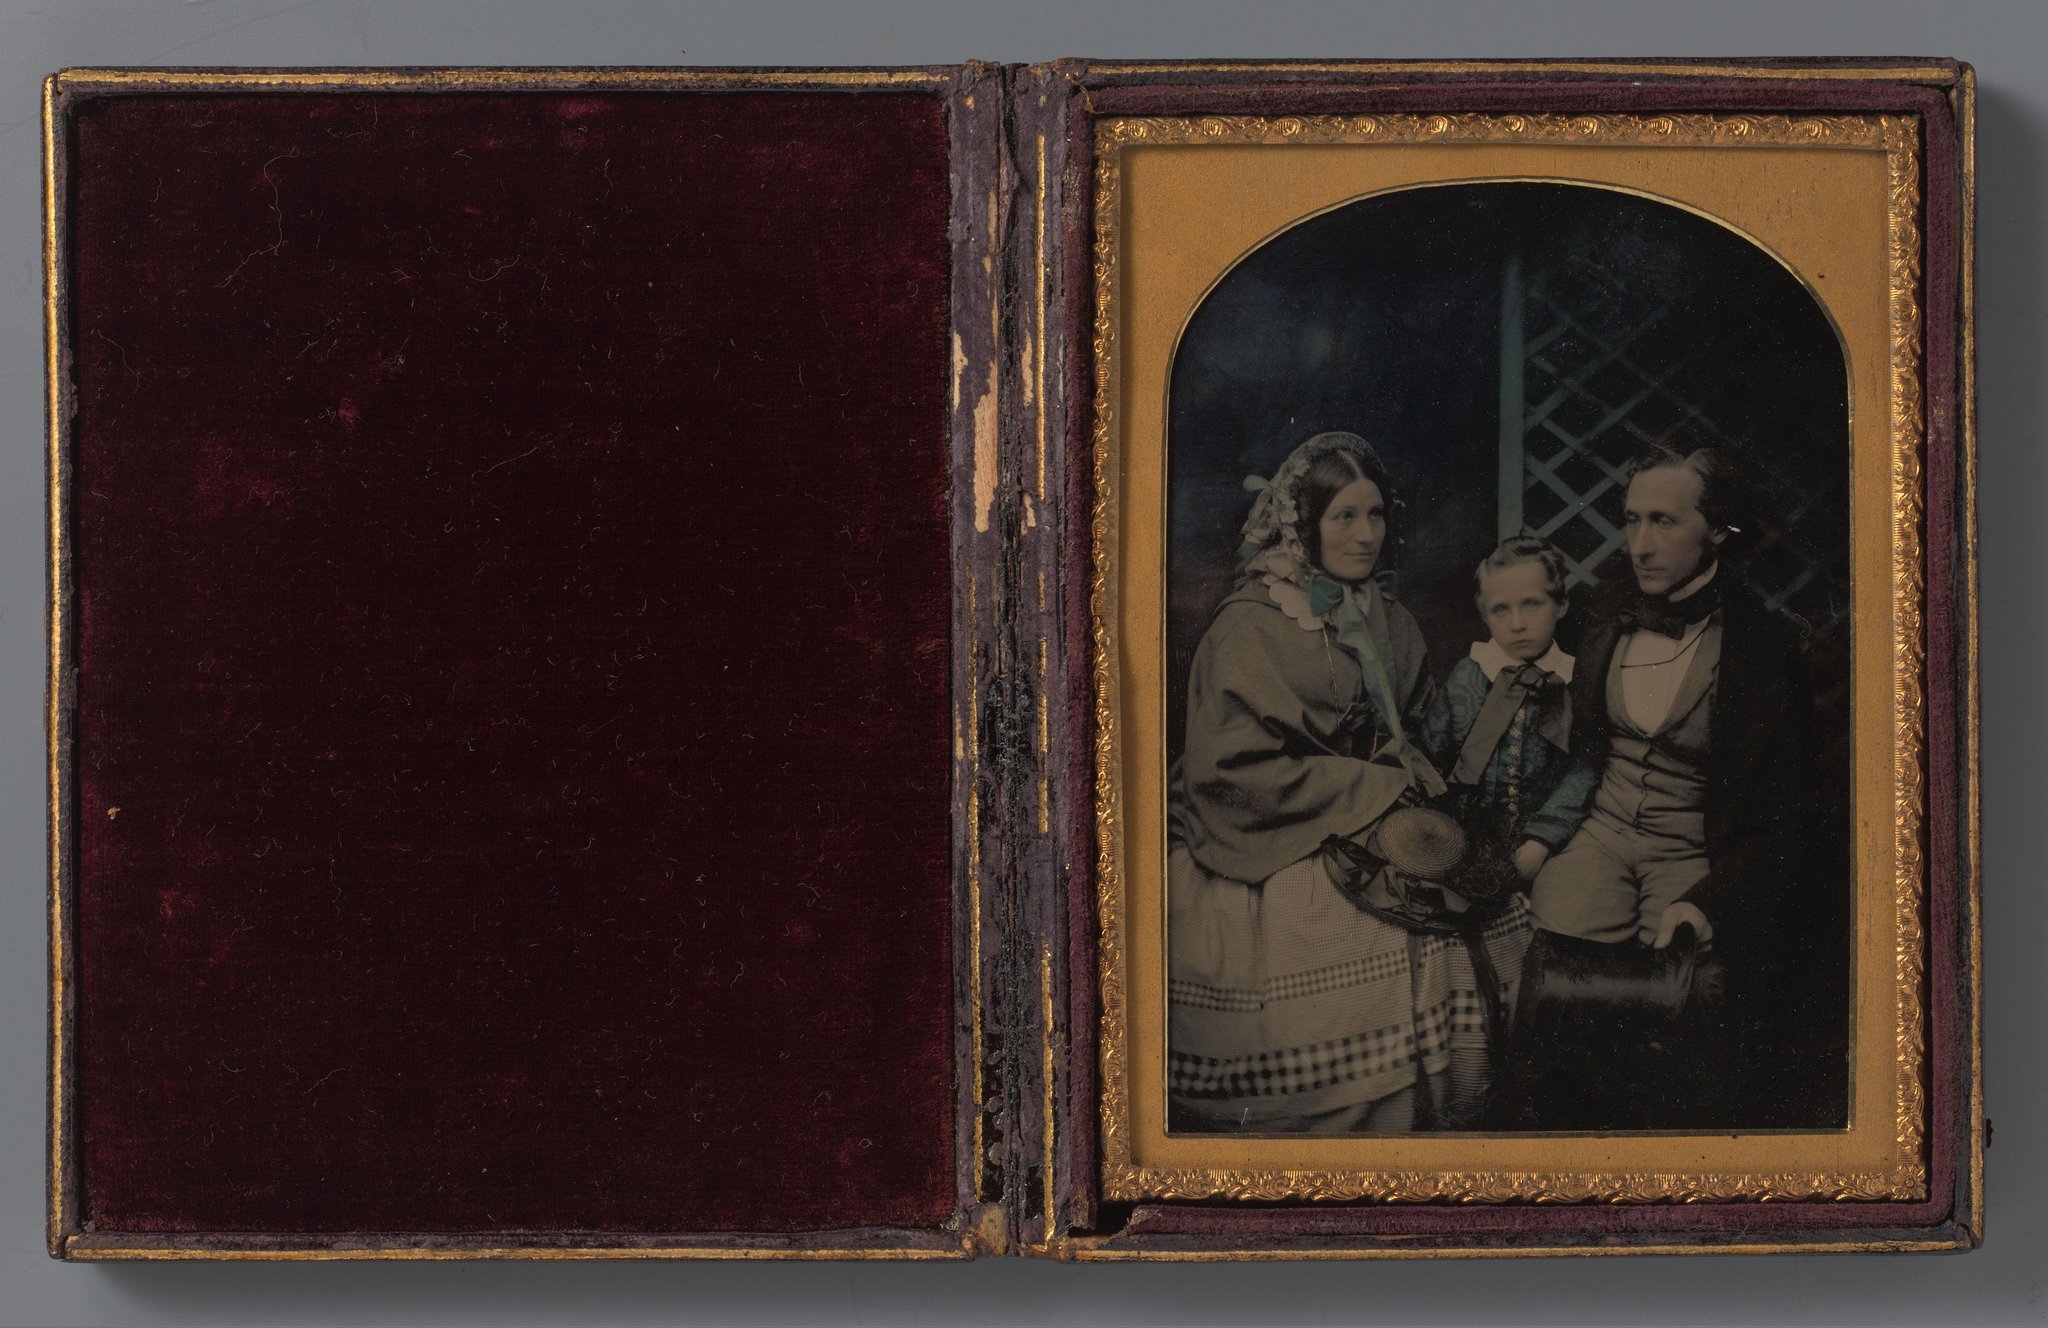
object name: photograph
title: Familieportret van een onbekende man, vrouw en kind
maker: Anonymous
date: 1855-1870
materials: glass, leather, metal, velvet, wood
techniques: ambrotype, hand coloring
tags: historical persons - bb - woman, boy (child between toddler and youth), historical persons